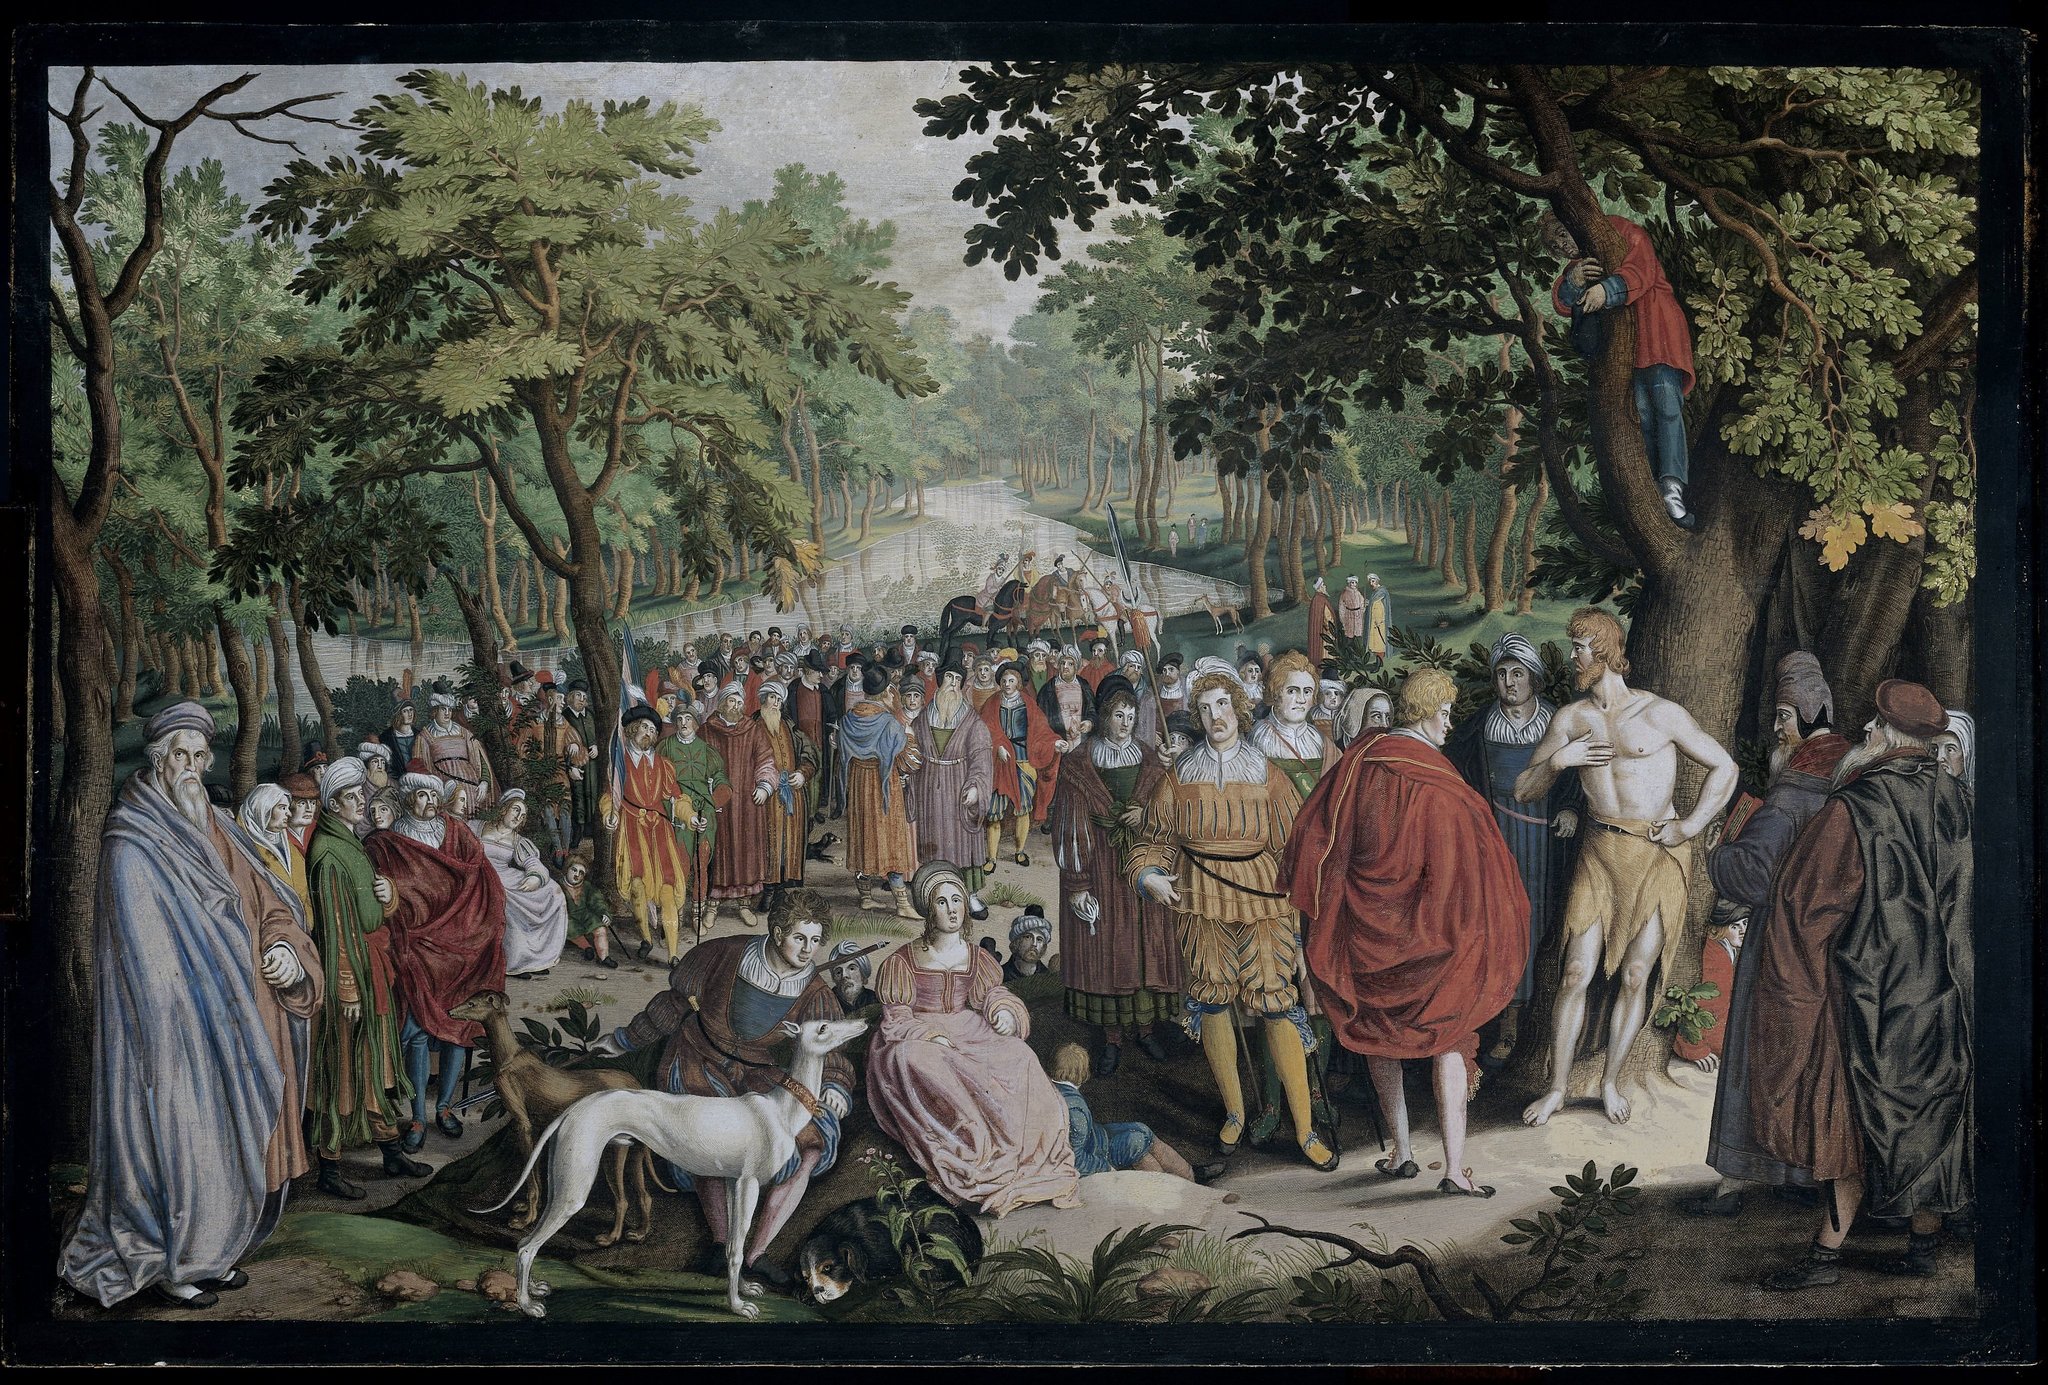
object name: watercolor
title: De prediking van Johannes de Doper aan de oevers van de Jordaan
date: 1619-1672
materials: gouache, paper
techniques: brush, engraving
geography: netherlands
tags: dog (with name of kind), john the baptist disputing, climbing up a tree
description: Johannes de Doper, predikend voor een grote menigte. In de boom boven hem zit een jongen. Middenvoor een elegant geklede dame en heer met hond. Op de achtergrond stroomt de rivier de Jordaan. De gravure is gekleurd en gehoogd met goud door Magdalena Fürst die op deze manier de prent veranderde in een 'schilderij'.